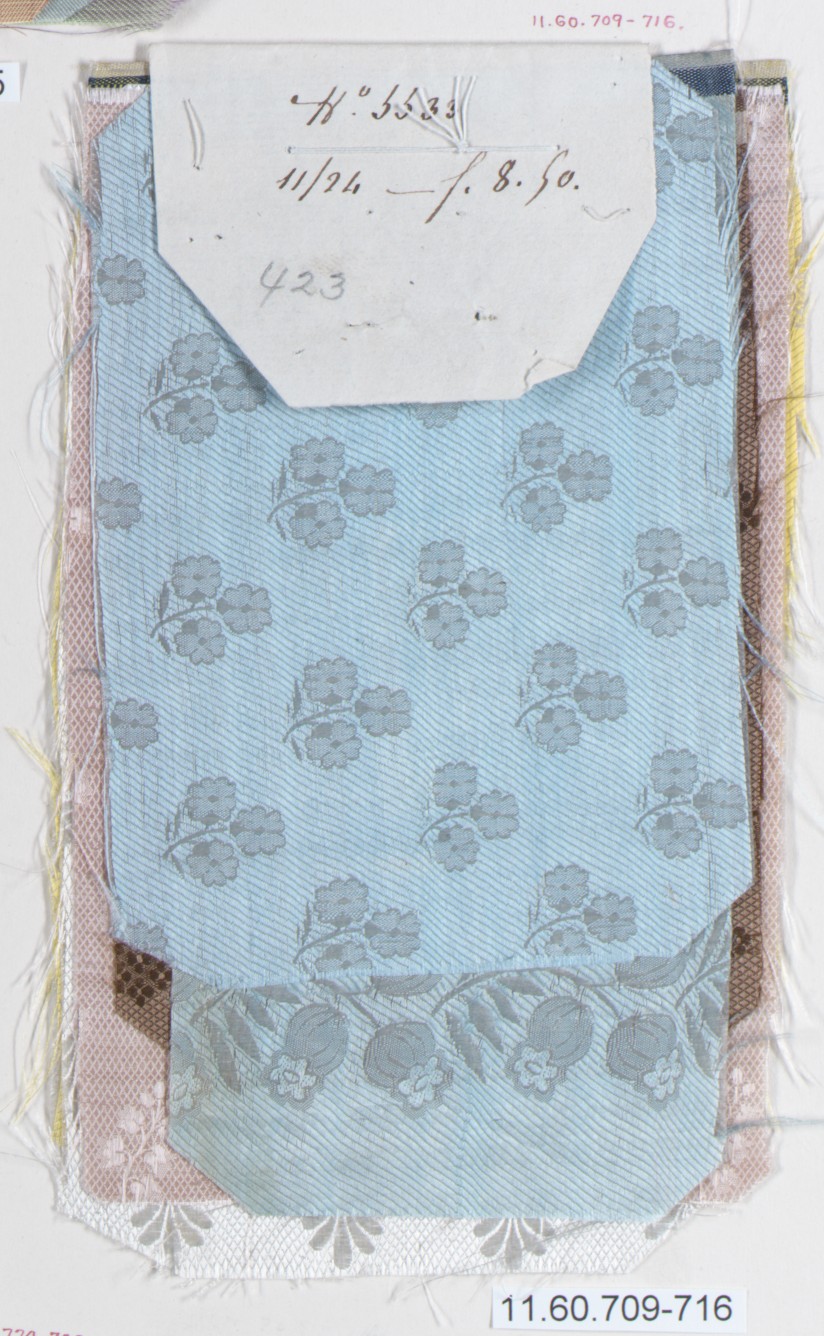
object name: sample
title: Samples (8)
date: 1801-1850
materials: silk